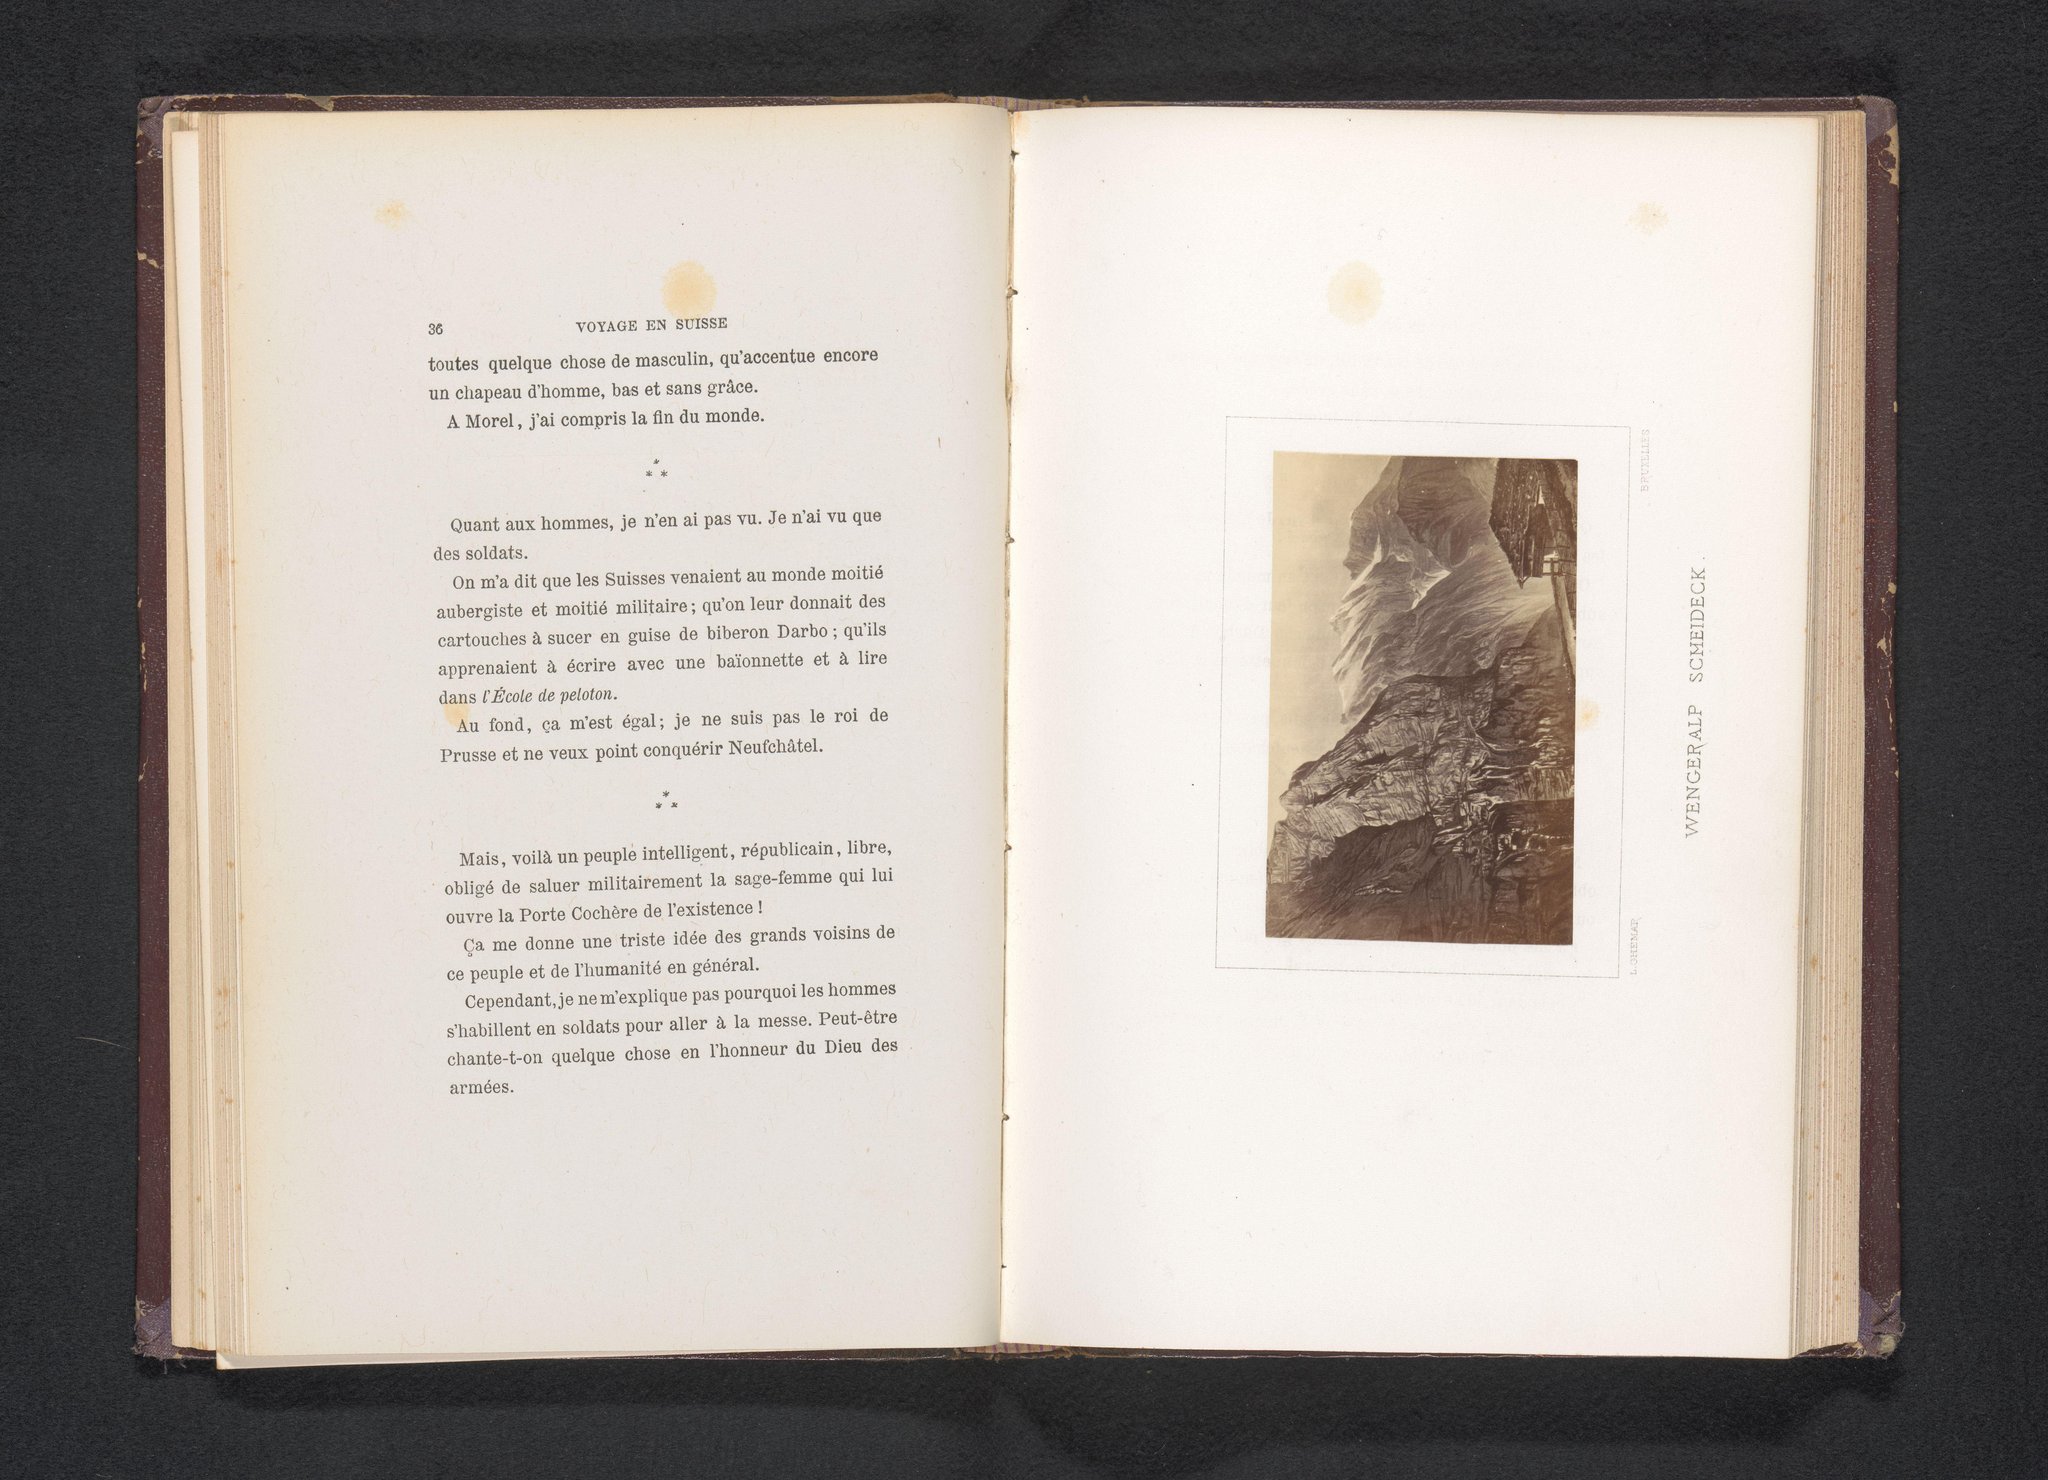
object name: page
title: Wengeralp Scheideck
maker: louis ghémar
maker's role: draughtsman, print maker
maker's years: 1819-1873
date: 1863-1868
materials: photographic support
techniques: albumen print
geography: lauterbrunnen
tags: mountains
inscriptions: inscription: ‘Bruxelles’